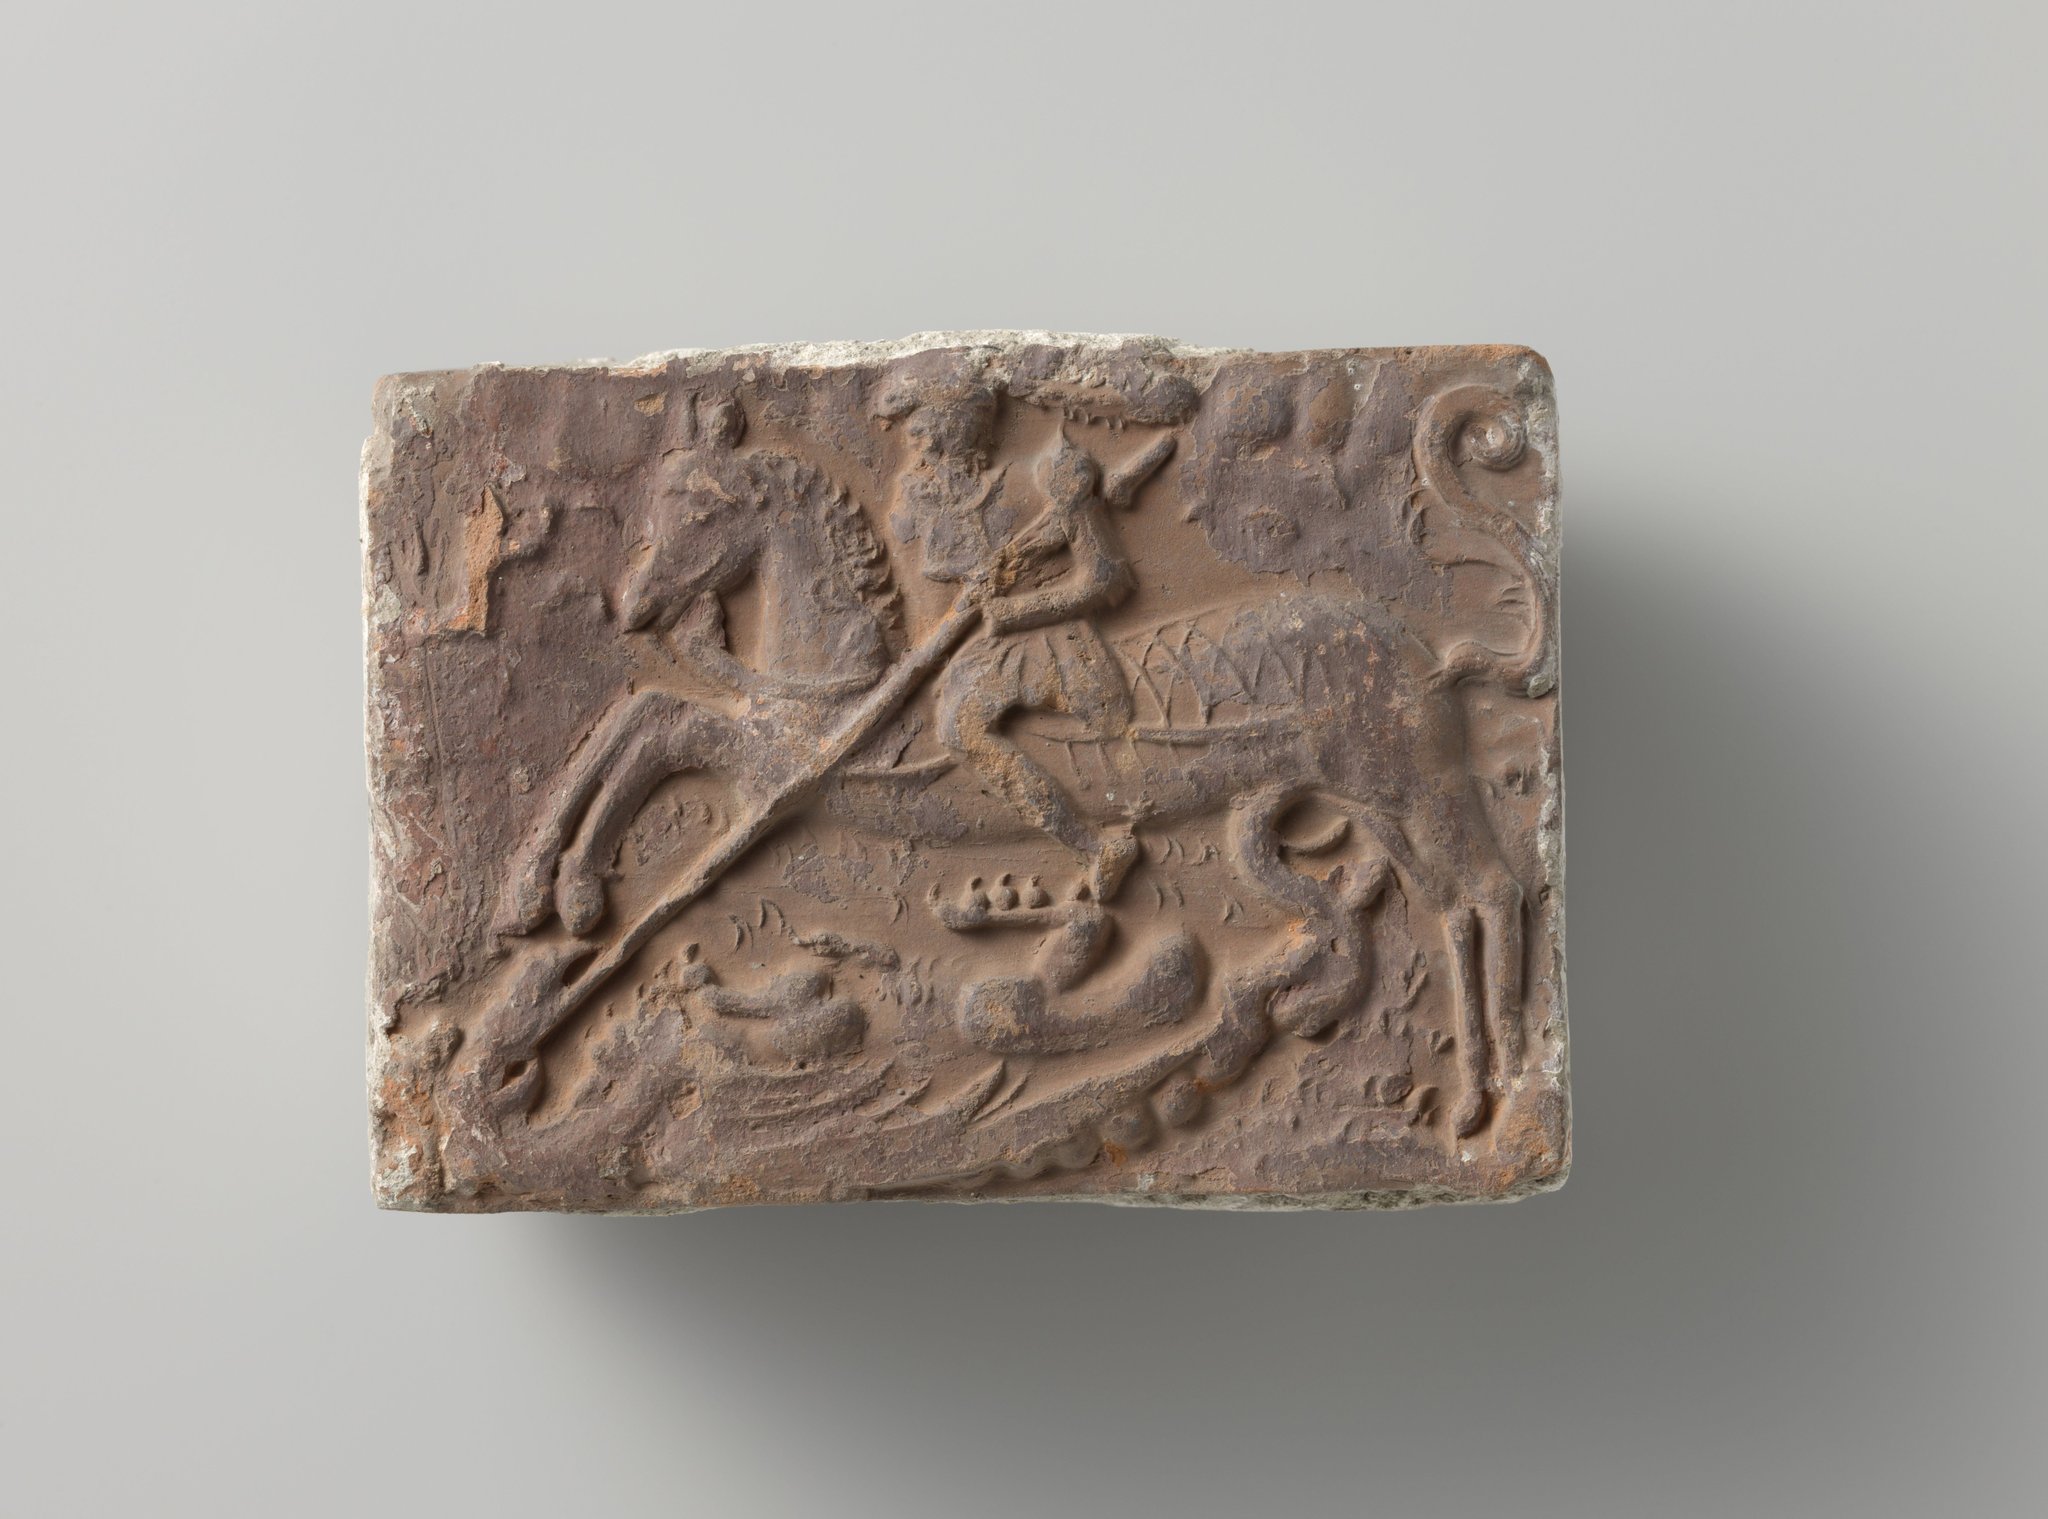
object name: hearthstone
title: Haardsteen met voorstelling van Sint Joris te paard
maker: Anonymous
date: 1575-1599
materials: earthenware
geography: antwerp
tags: st. george and the dragon: dressed in armour and mounted on a (white) horse he brandishes his sword (his lance lies already broken on the ground); the princess nearby may be shown praying or fleeing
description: Een vergelijkbare steen is afkomstig uit het huis Nieuwengracht 58, zie: H. Lägers, Hersteen en Cronement, Utrecht, 2006, cat. 181